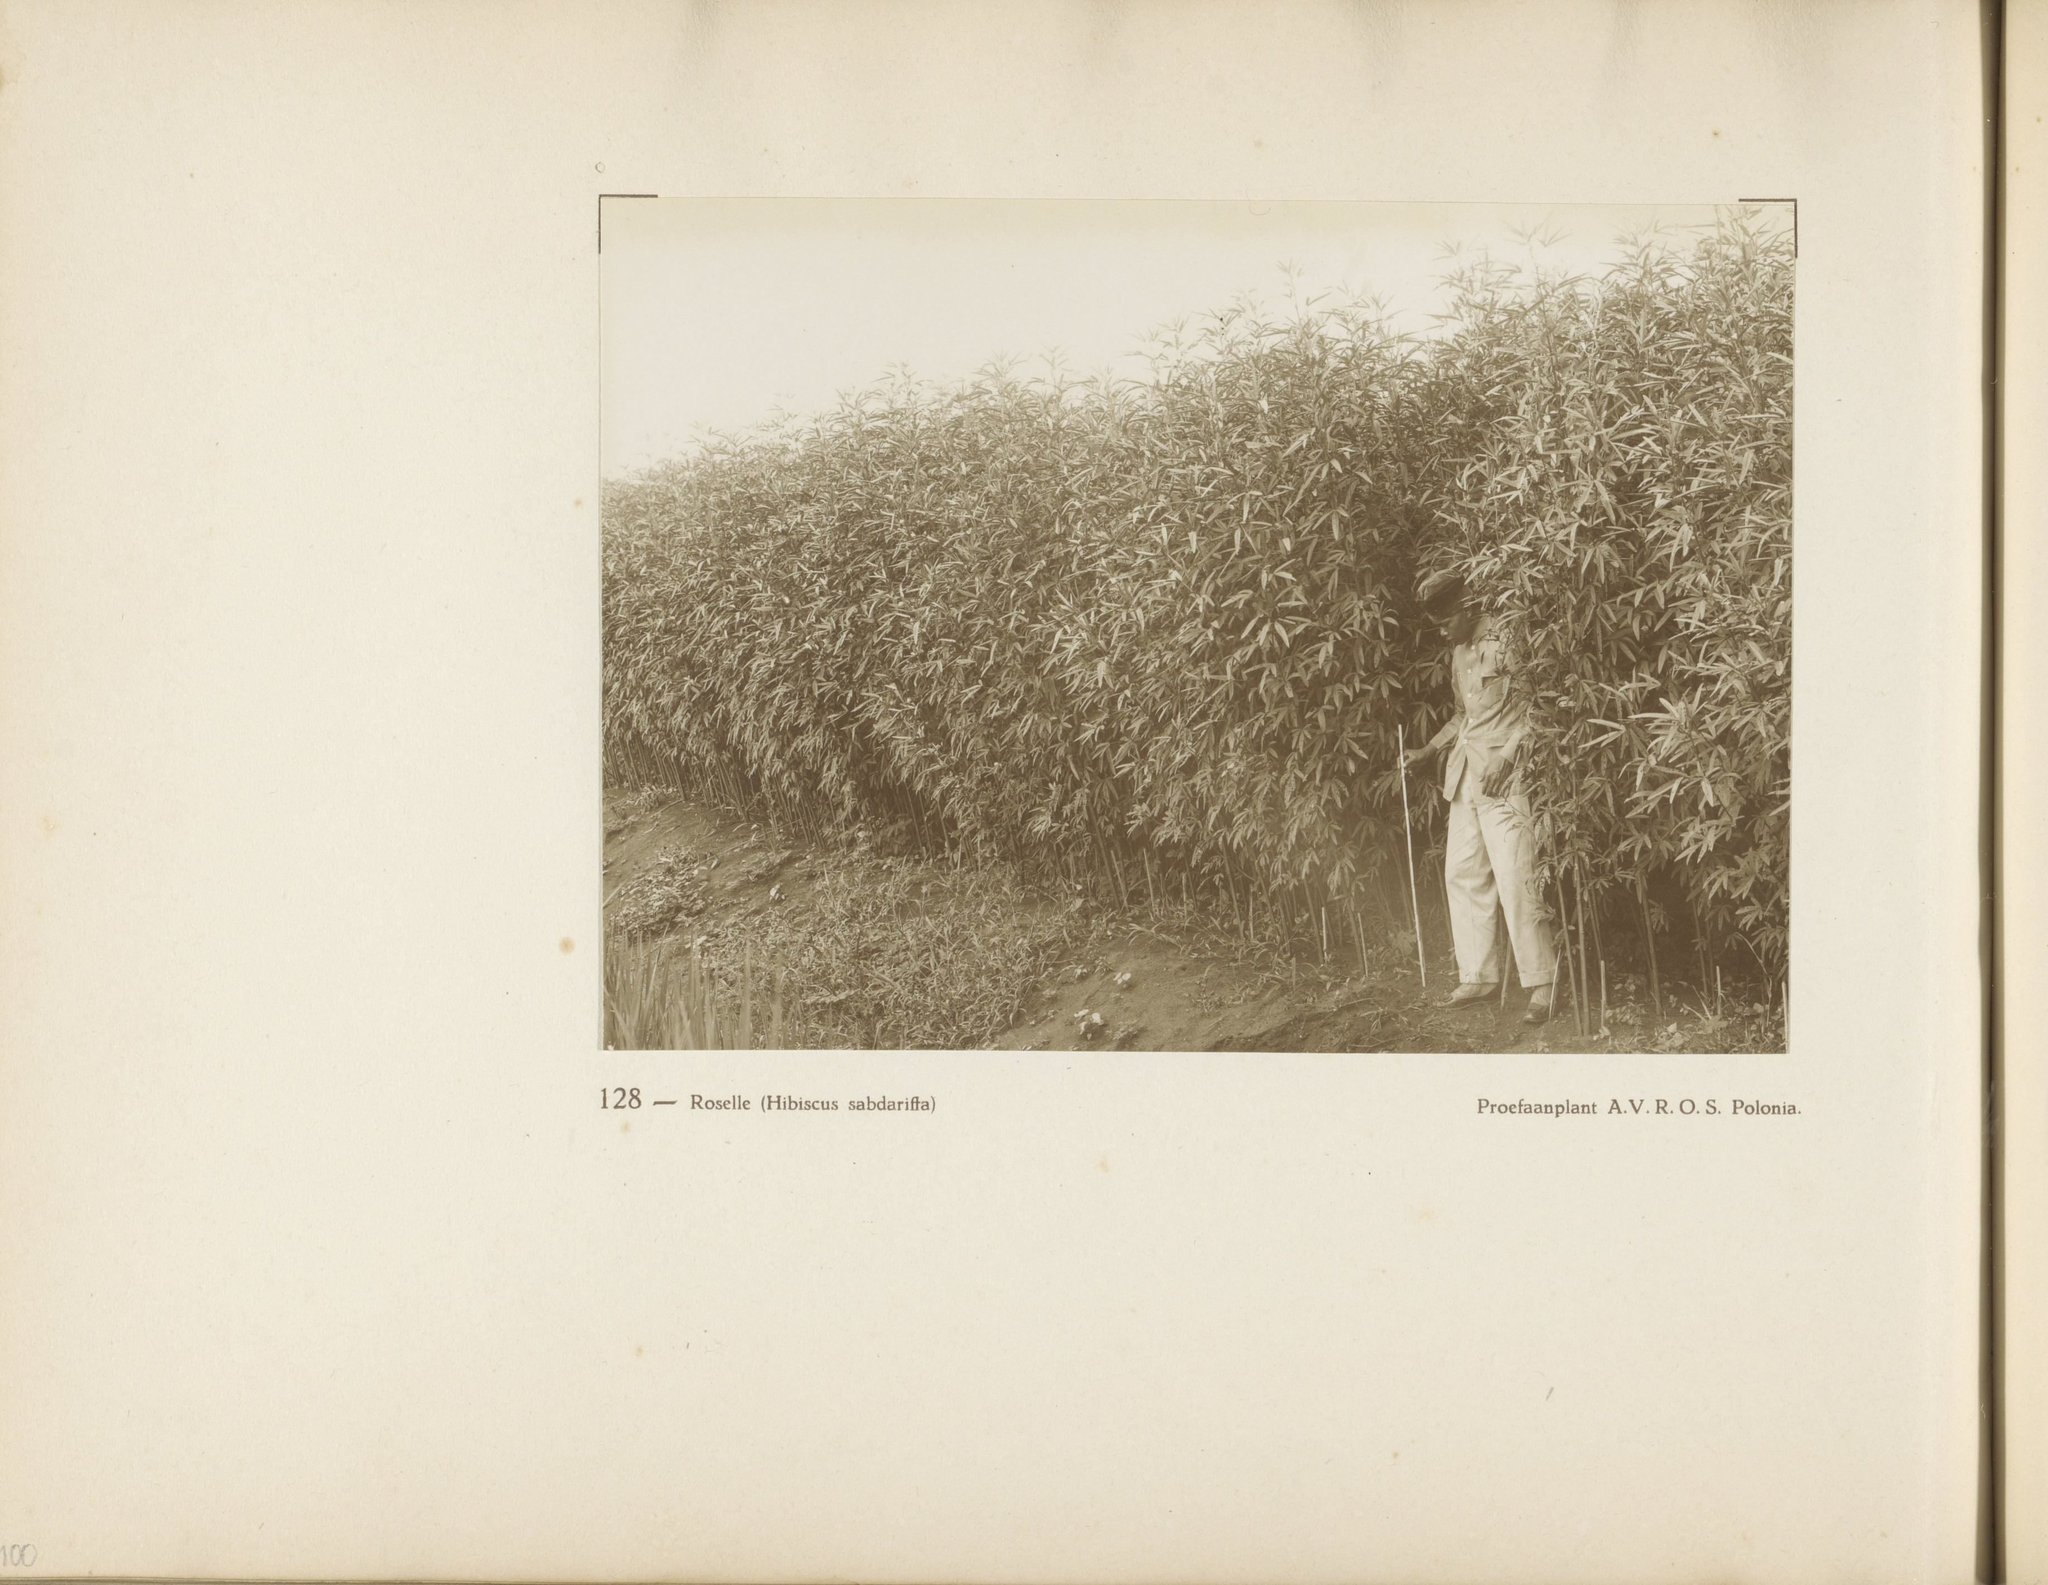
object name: photograph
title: Pagina 128 van fotoboek van de Algemeene Vereeniging van Rubberplanters ter Oostkust van Sumatra (A.V.R.O.S.)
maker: j.w. meyster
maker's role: fotograaf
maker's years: 1887-1945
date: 1924-1925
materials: paper, photographic support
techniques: printing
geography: sumatra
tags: field filled with a crop, plants; vegetation, (non-fruit) products of plants or trees: rubber, measuring, sumatra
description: Boekpagina met een foto van een Indische man die roselle (Hibiscus sabdariffa) meet op een proefaanplant van de Algemeene Vereeniging van Rubberplanters ter Oostkust van Sumatra (A.V.R.O.S.) te Polonia. Onderdeel van een fotoboek van de Algemeene Vereeniging van Rubberplanters ter Oostkust van Sumatra (A.V.R.O.S.).